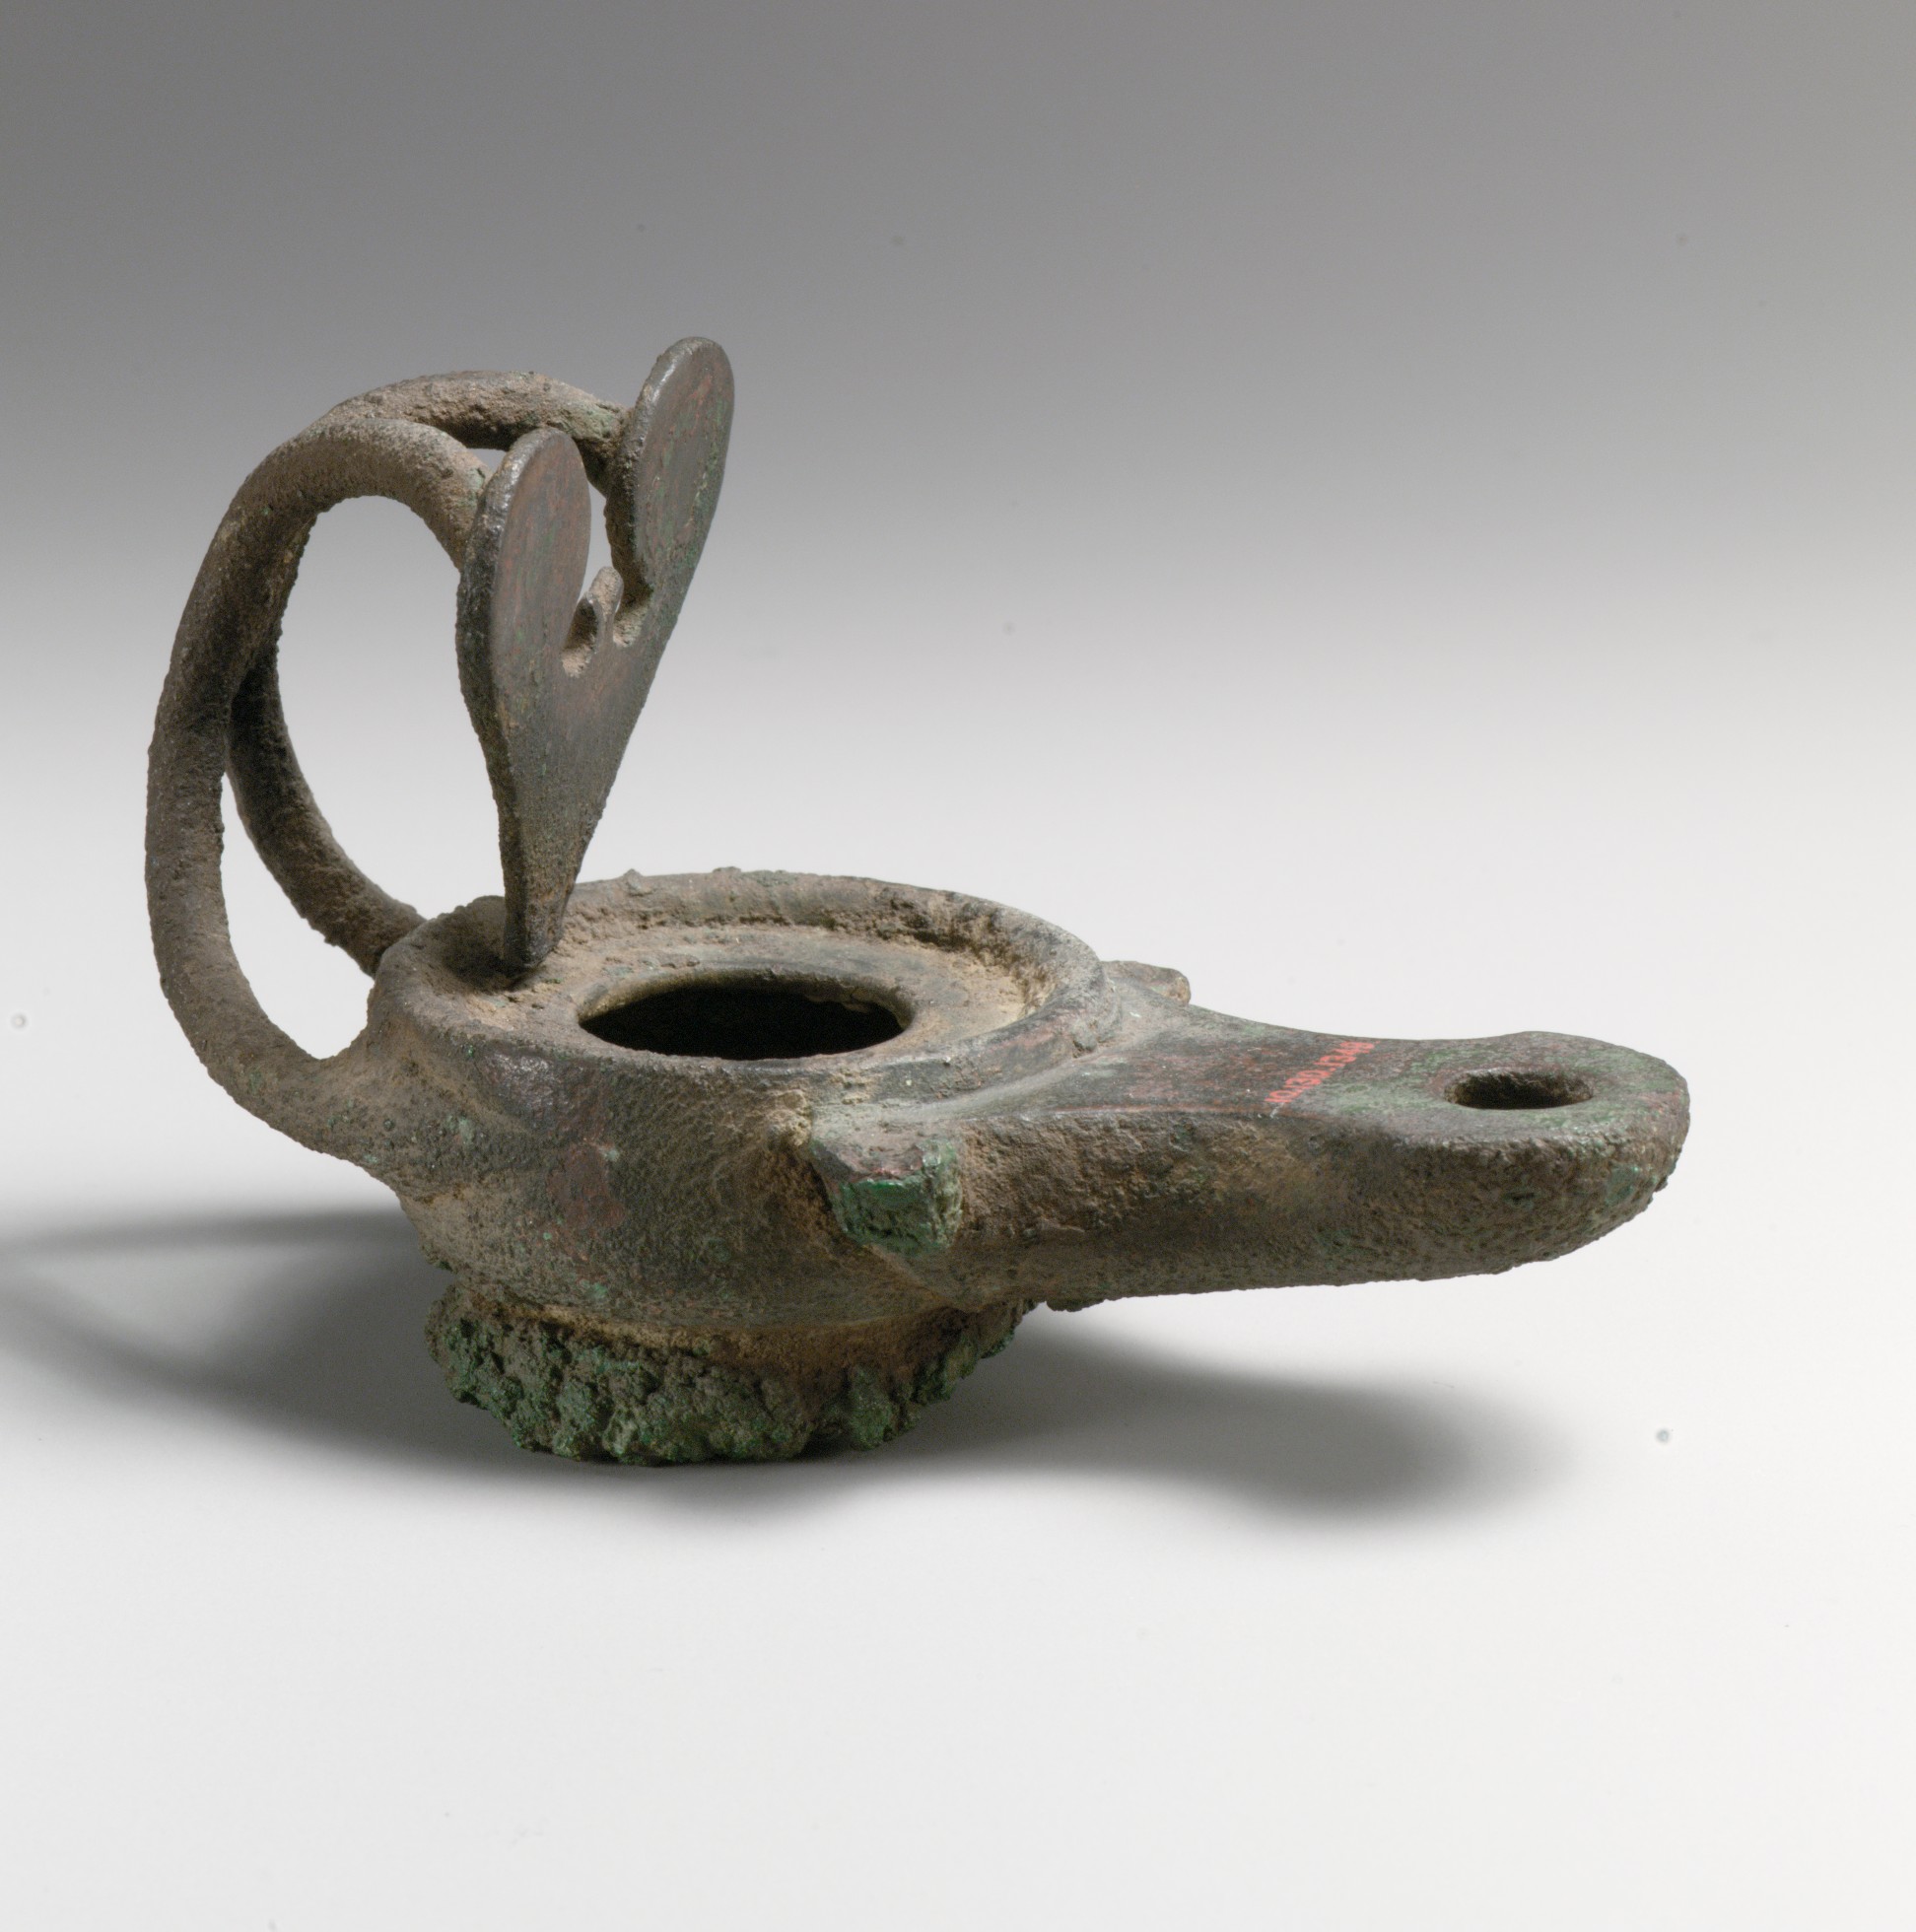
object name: lamp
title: Bronze lamp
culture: roman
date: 67-100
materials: bronze